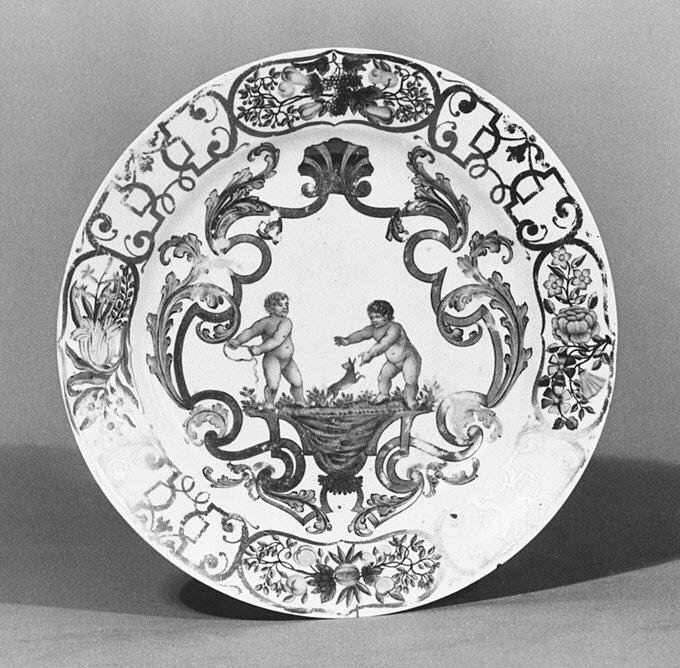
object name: plate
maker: meissen manufactory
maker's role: manufactory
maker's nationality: german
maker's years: 1710-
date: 1740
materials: hard paste porcelain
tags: putti,dogs